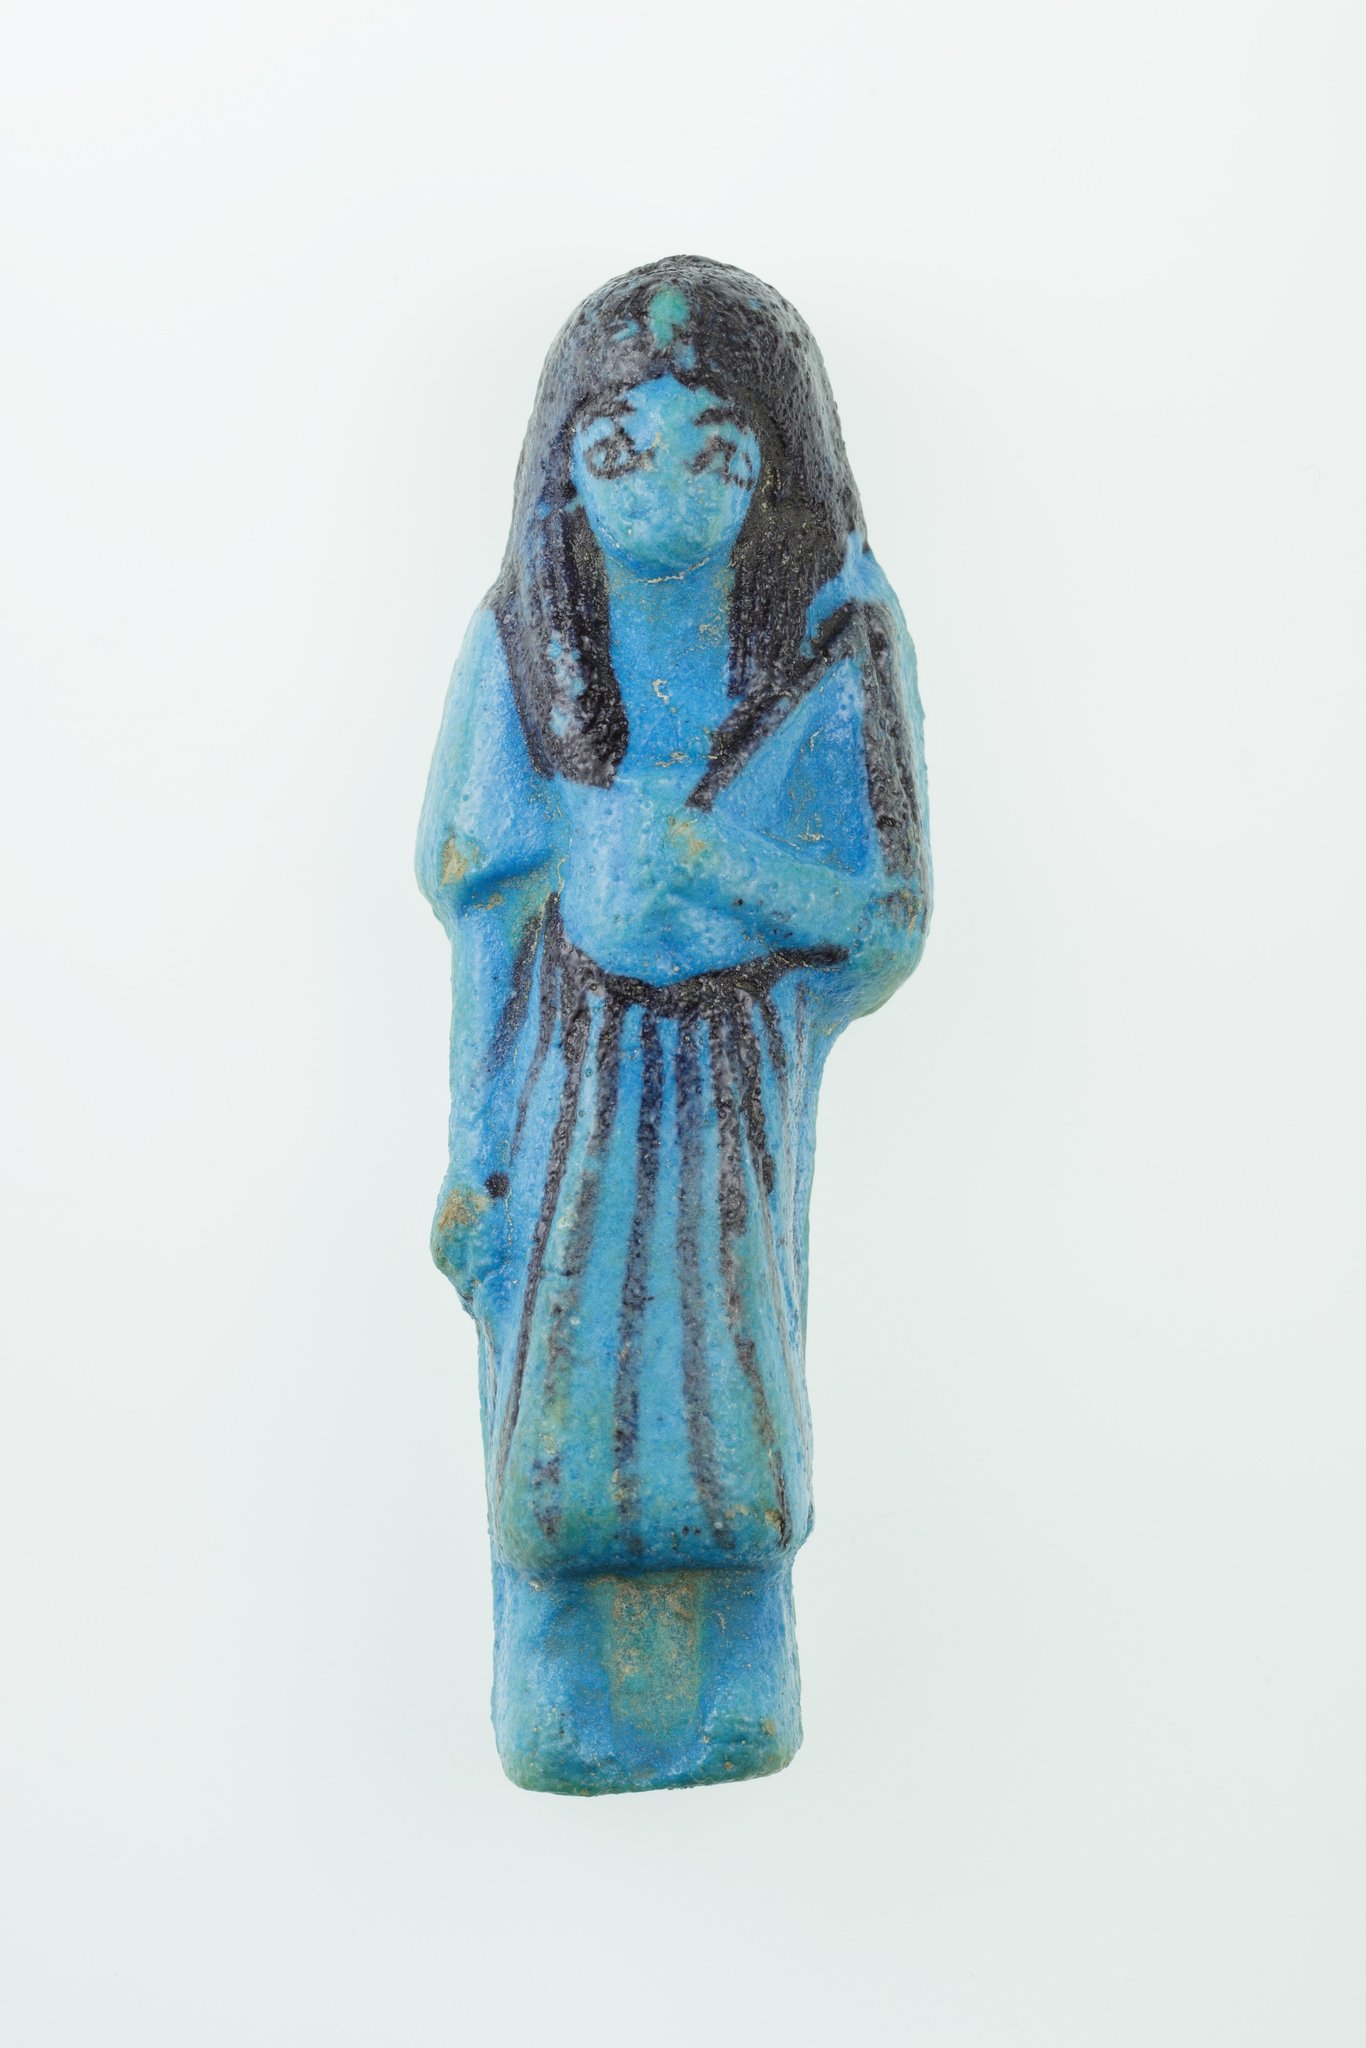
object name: shabti, overseer, nauny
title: Overseer Shabti of Nauny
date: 1050 BCE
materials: faience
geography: egypt